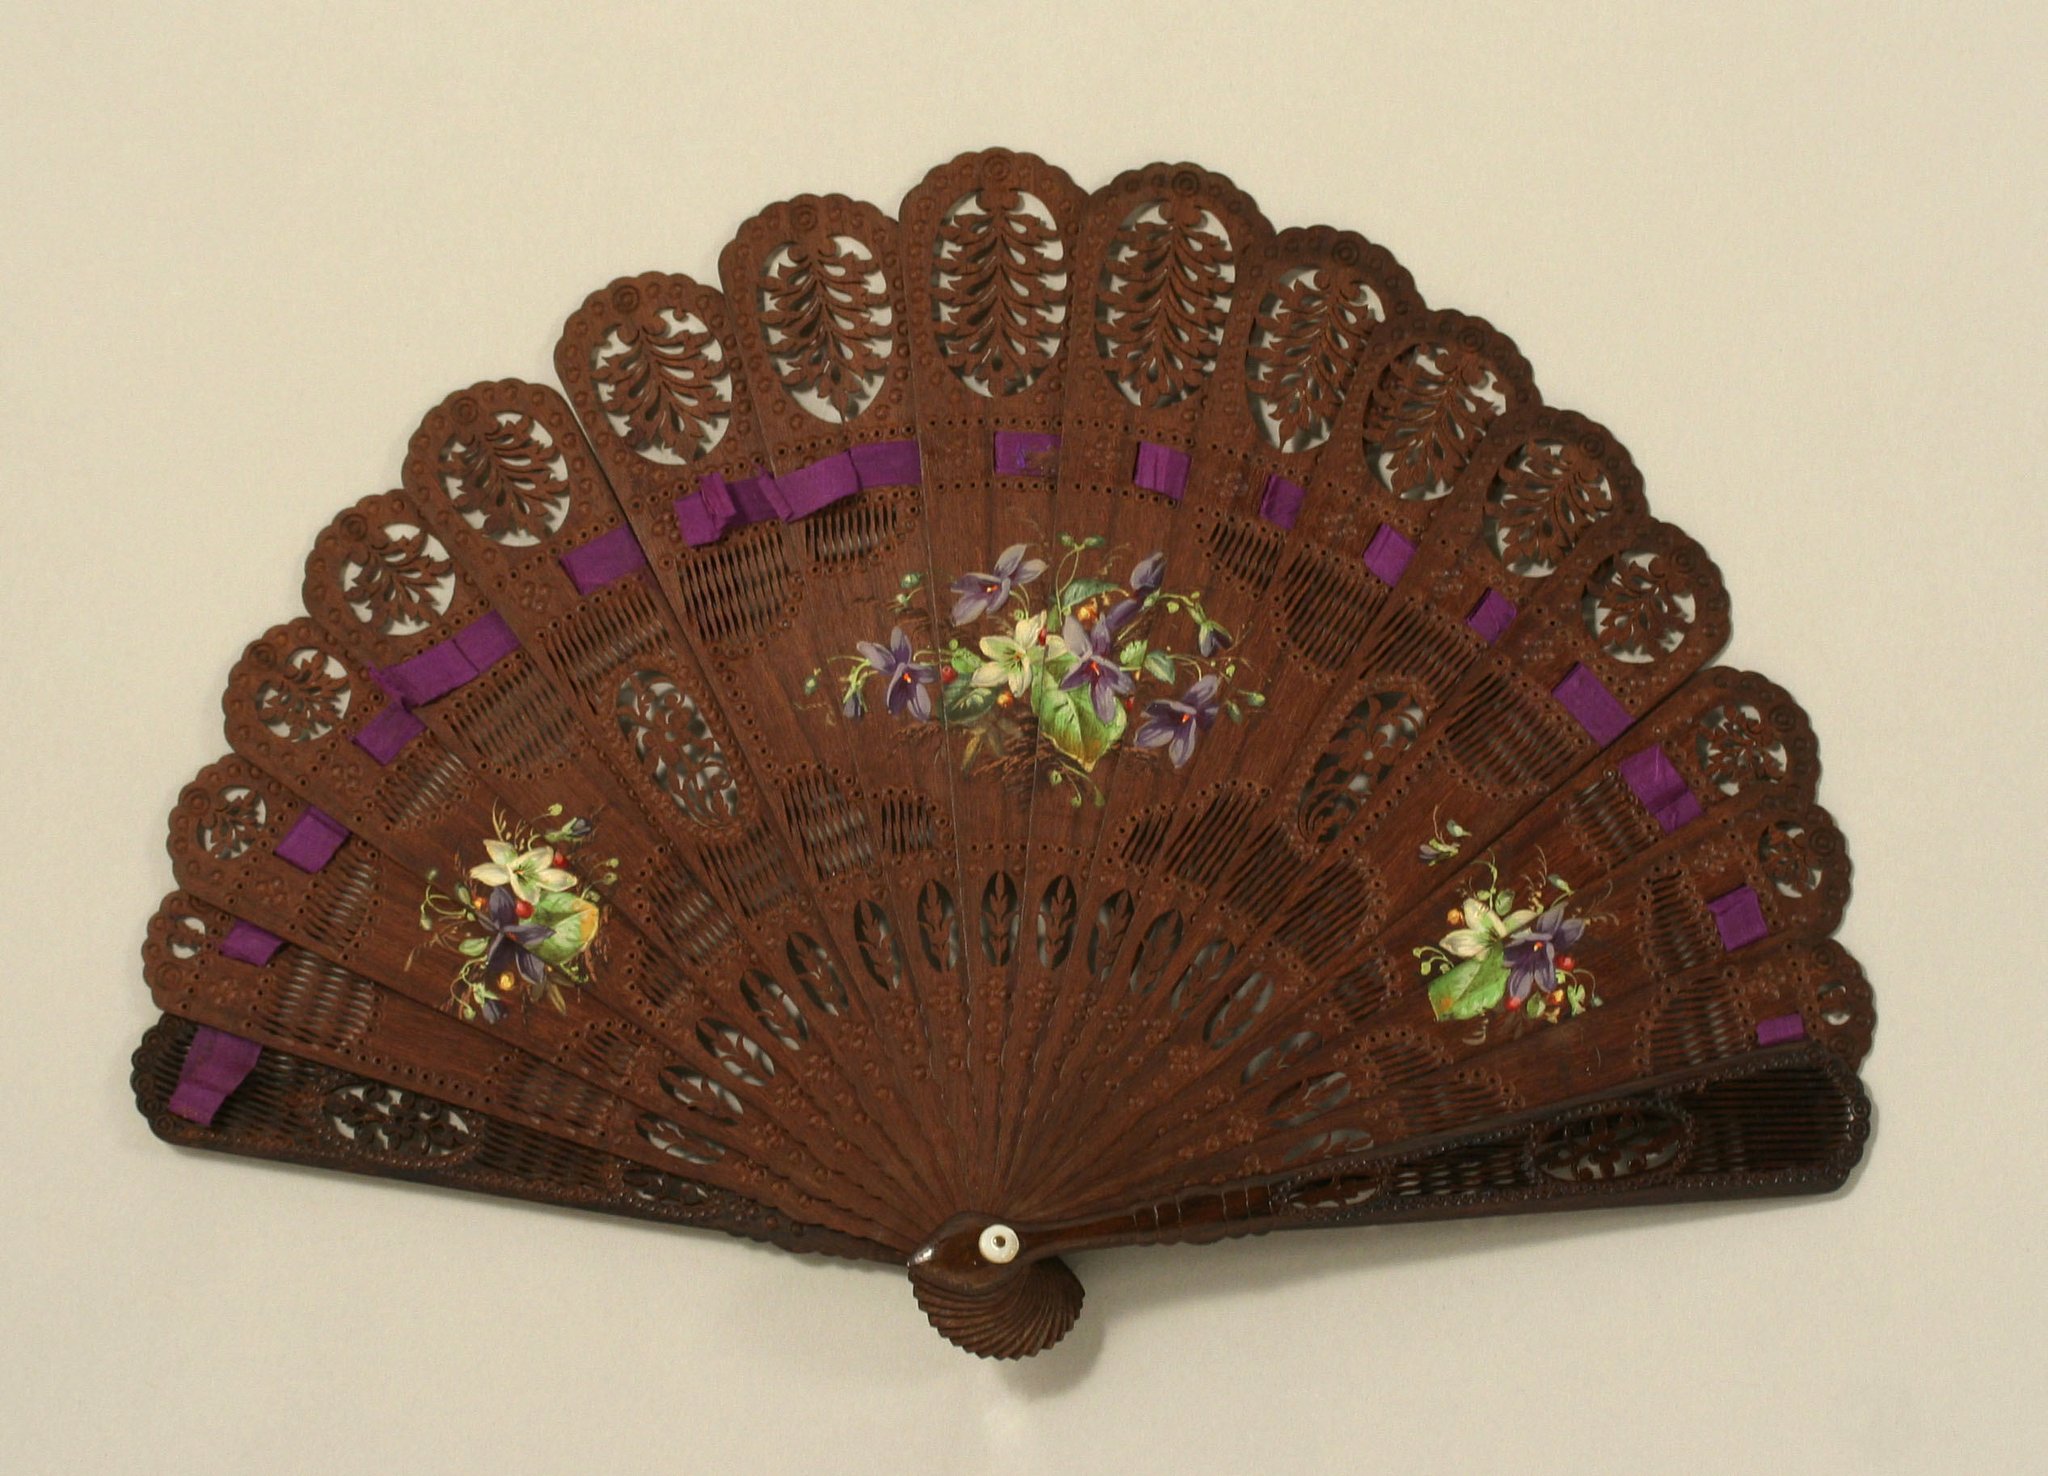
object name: brisé fan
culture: american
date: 1825-1850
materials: silk, wood